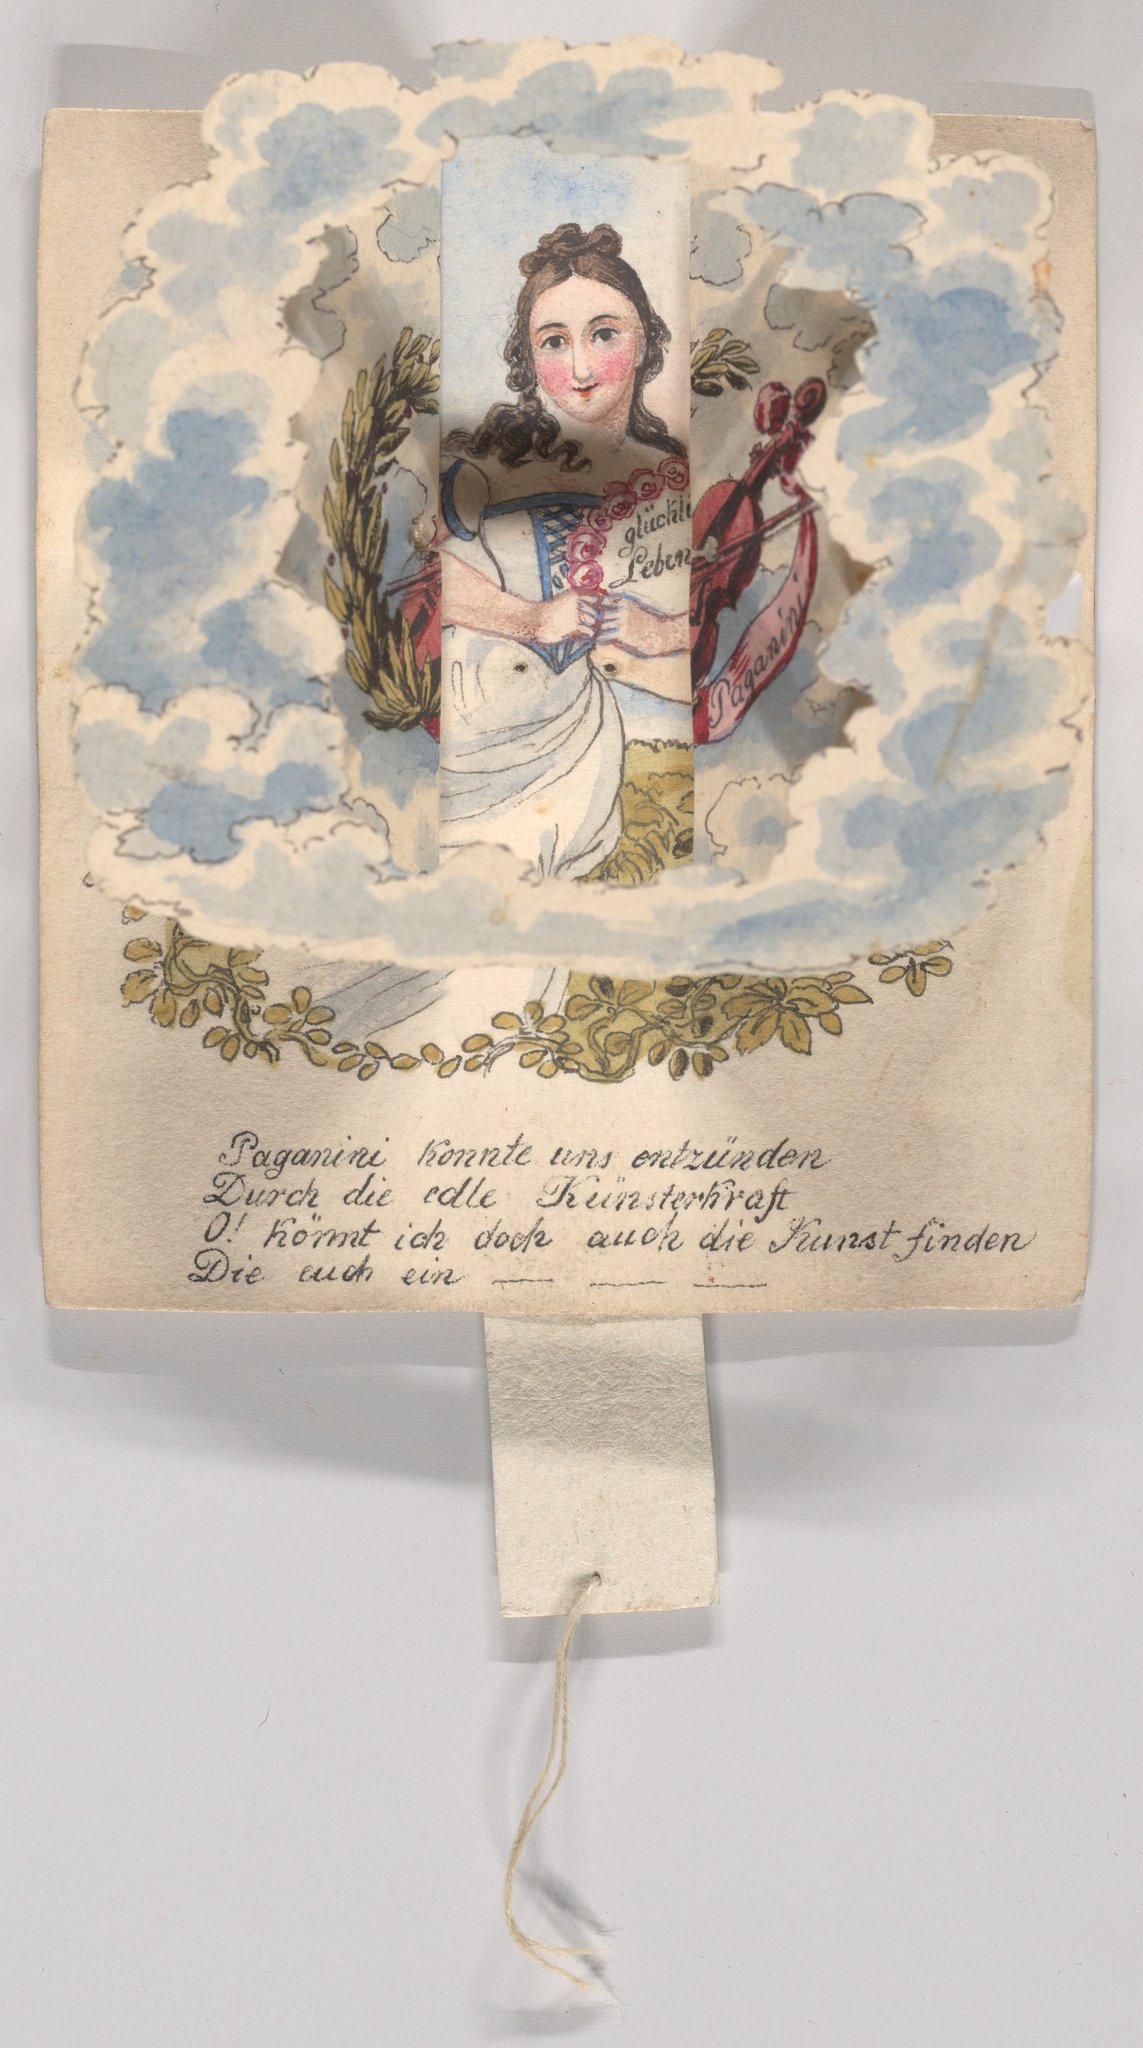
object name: greeting card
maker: joseph jakob martin eder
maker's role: publisher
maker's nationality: austrian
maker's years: 1759-1835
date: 1820-1830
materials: ink, thread, watercolor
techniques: pen